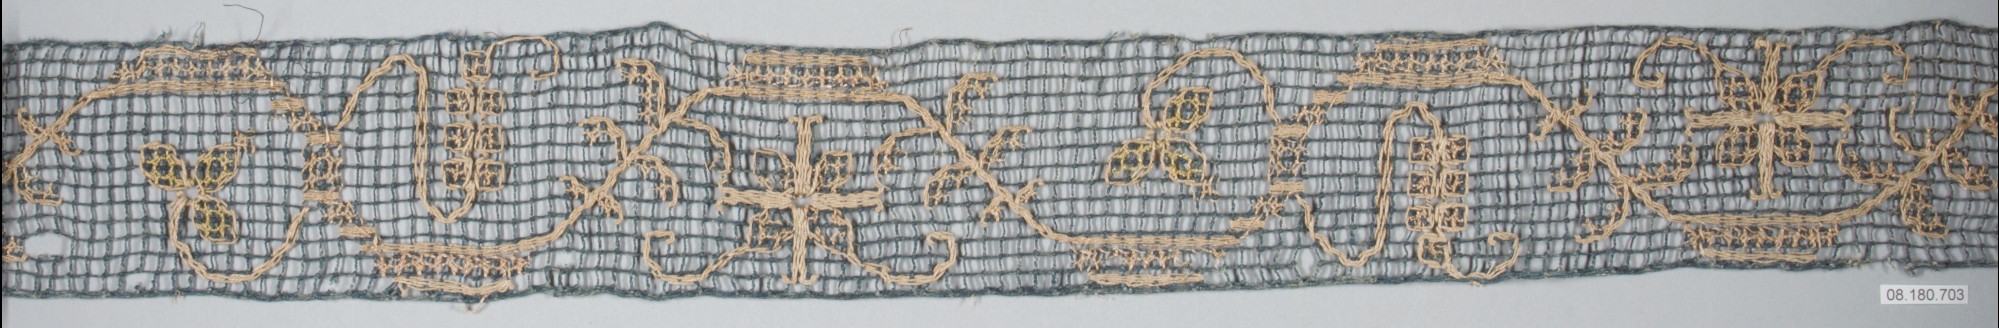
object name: piece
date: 1601-1700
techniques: embroidery